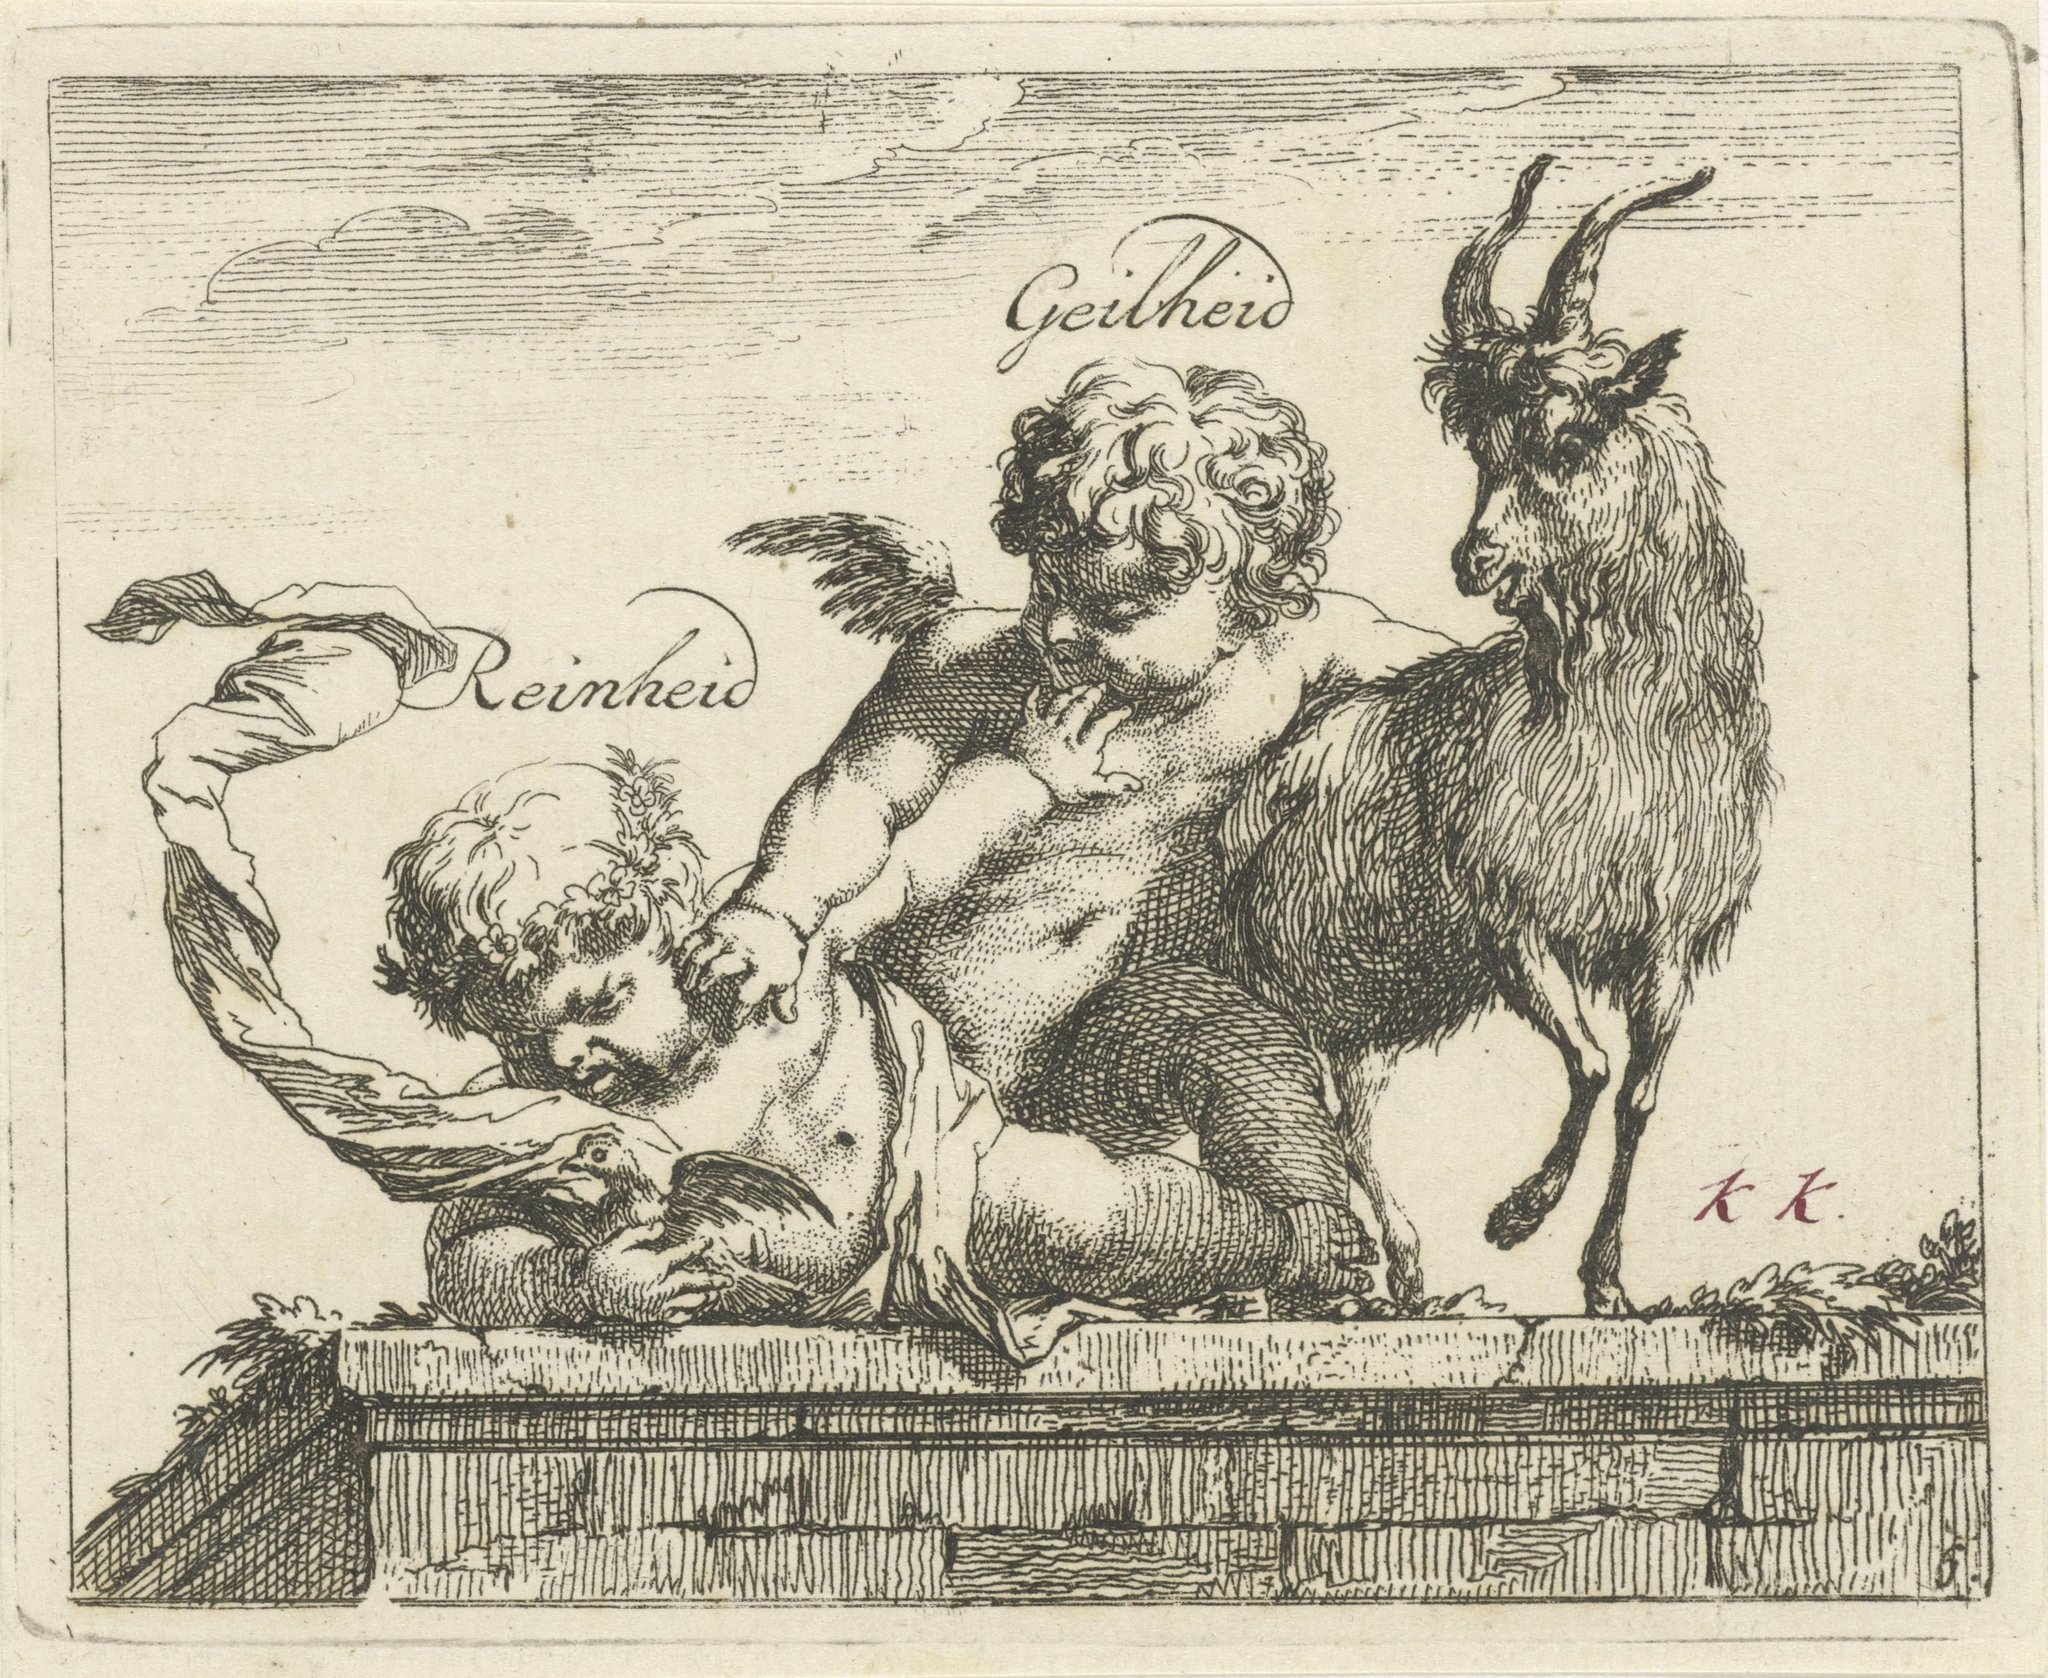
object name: print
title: Reinheid Geilheid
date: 1710-1719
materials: paper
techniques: etching, pen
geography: amsterdam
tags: he-goat, billy-goat, angel(s) represented as child(ren), distinction between good and bad; 'distintione del bene & del male' (ripa)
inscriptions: inscription: ‘k.k’, collector's mark: Lugt 2228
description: Twee vechtende putti. Links de verbeelding van geilheid, zijn arm om een bok. Hij overmeestert Reinheid die op de grond ligt. Prent uit een serie van 41 zinnebeelden.